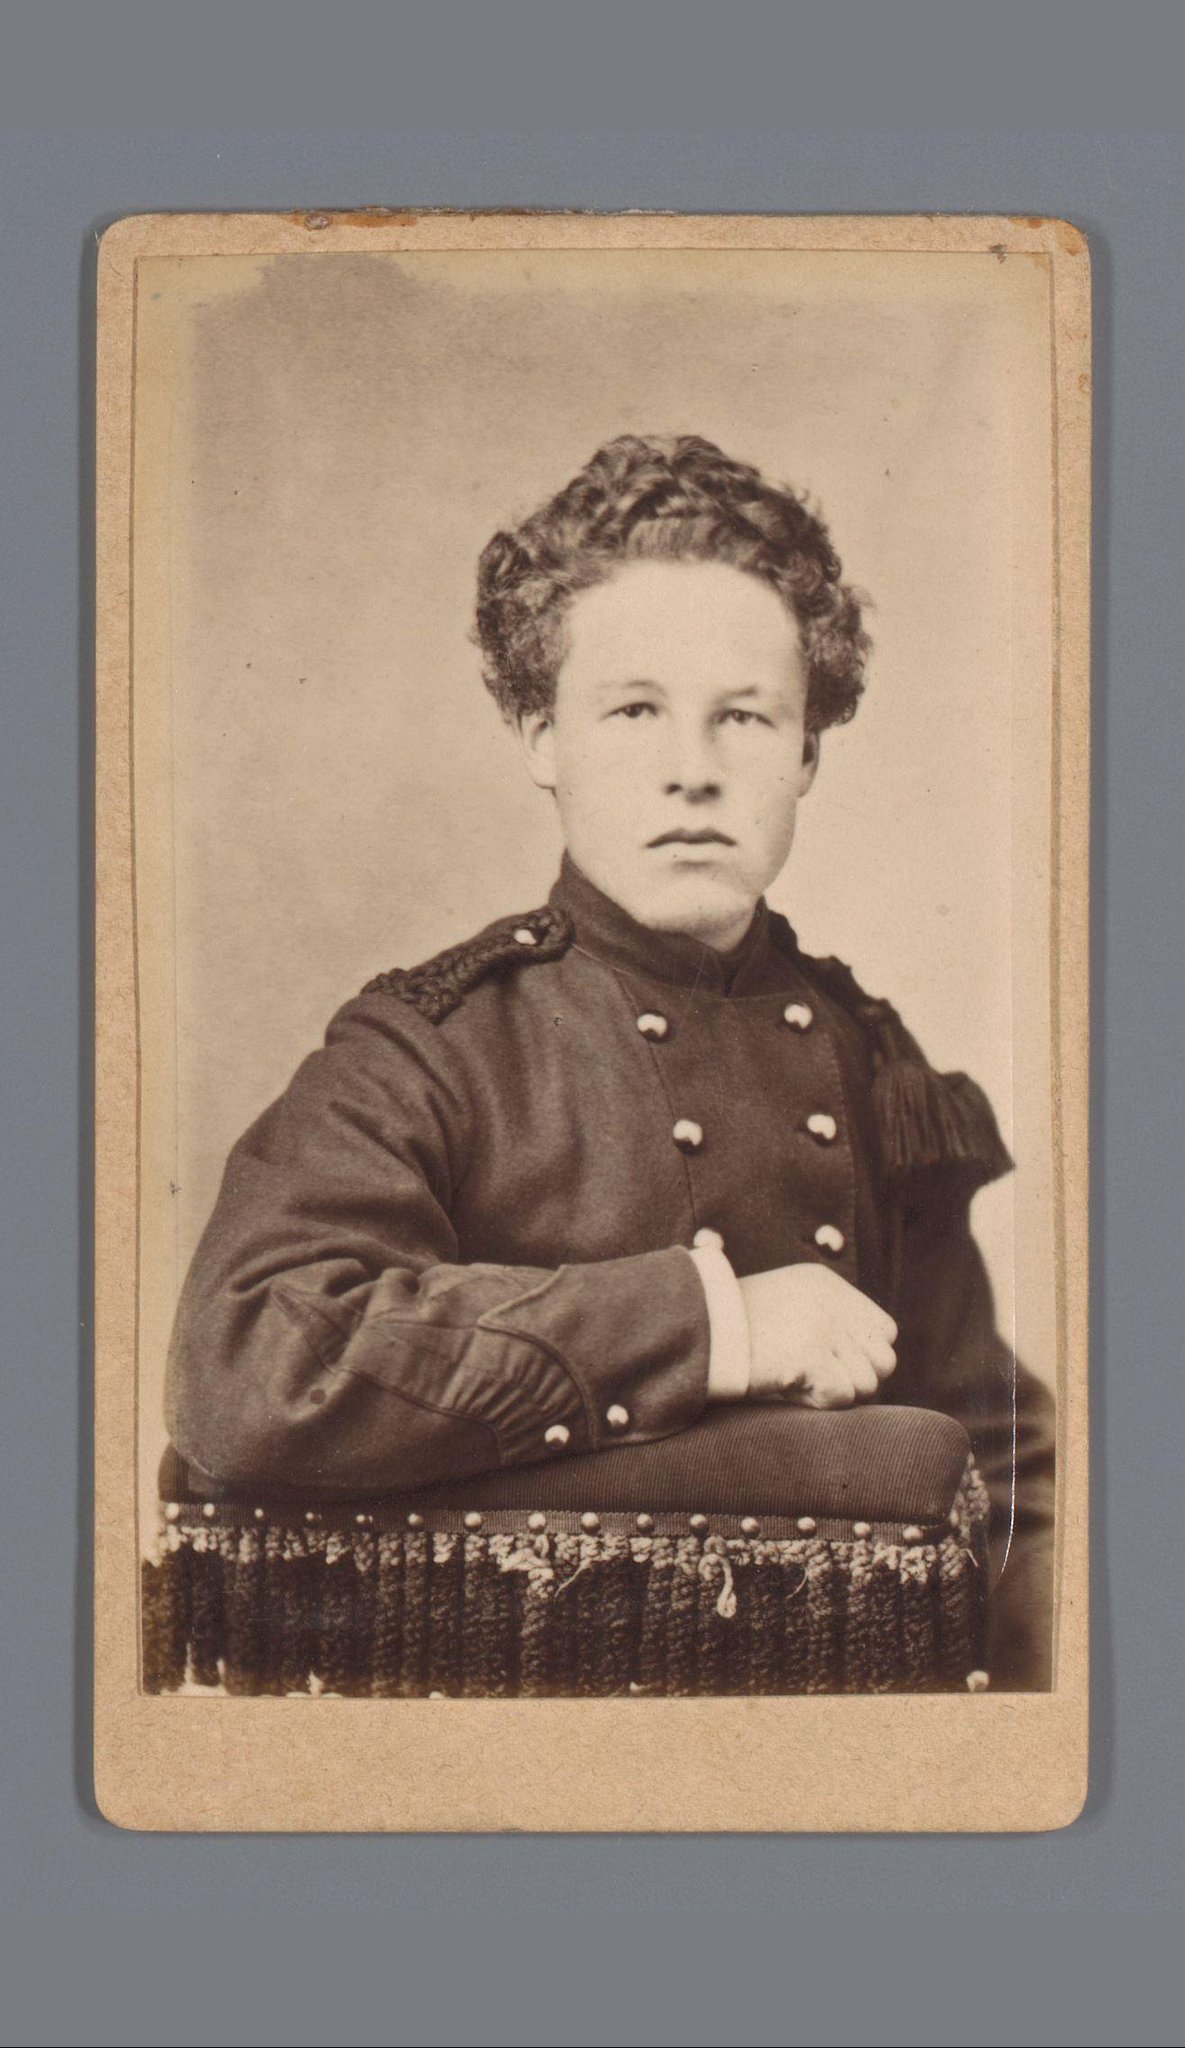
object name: photograph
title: Portret van een onbekende man in uniform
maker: august ferdinand heinrich harms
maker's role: fotograaf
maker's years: 1845-1916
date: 1880-1882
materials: cardboard, celluloid, paper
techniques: albumen print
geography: leiden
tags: adult man, historical persons, (military) uniforms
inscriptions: inscription: ‘PHOTOGRAPHIE/ van/ H. Harms/ LEIDEN.’